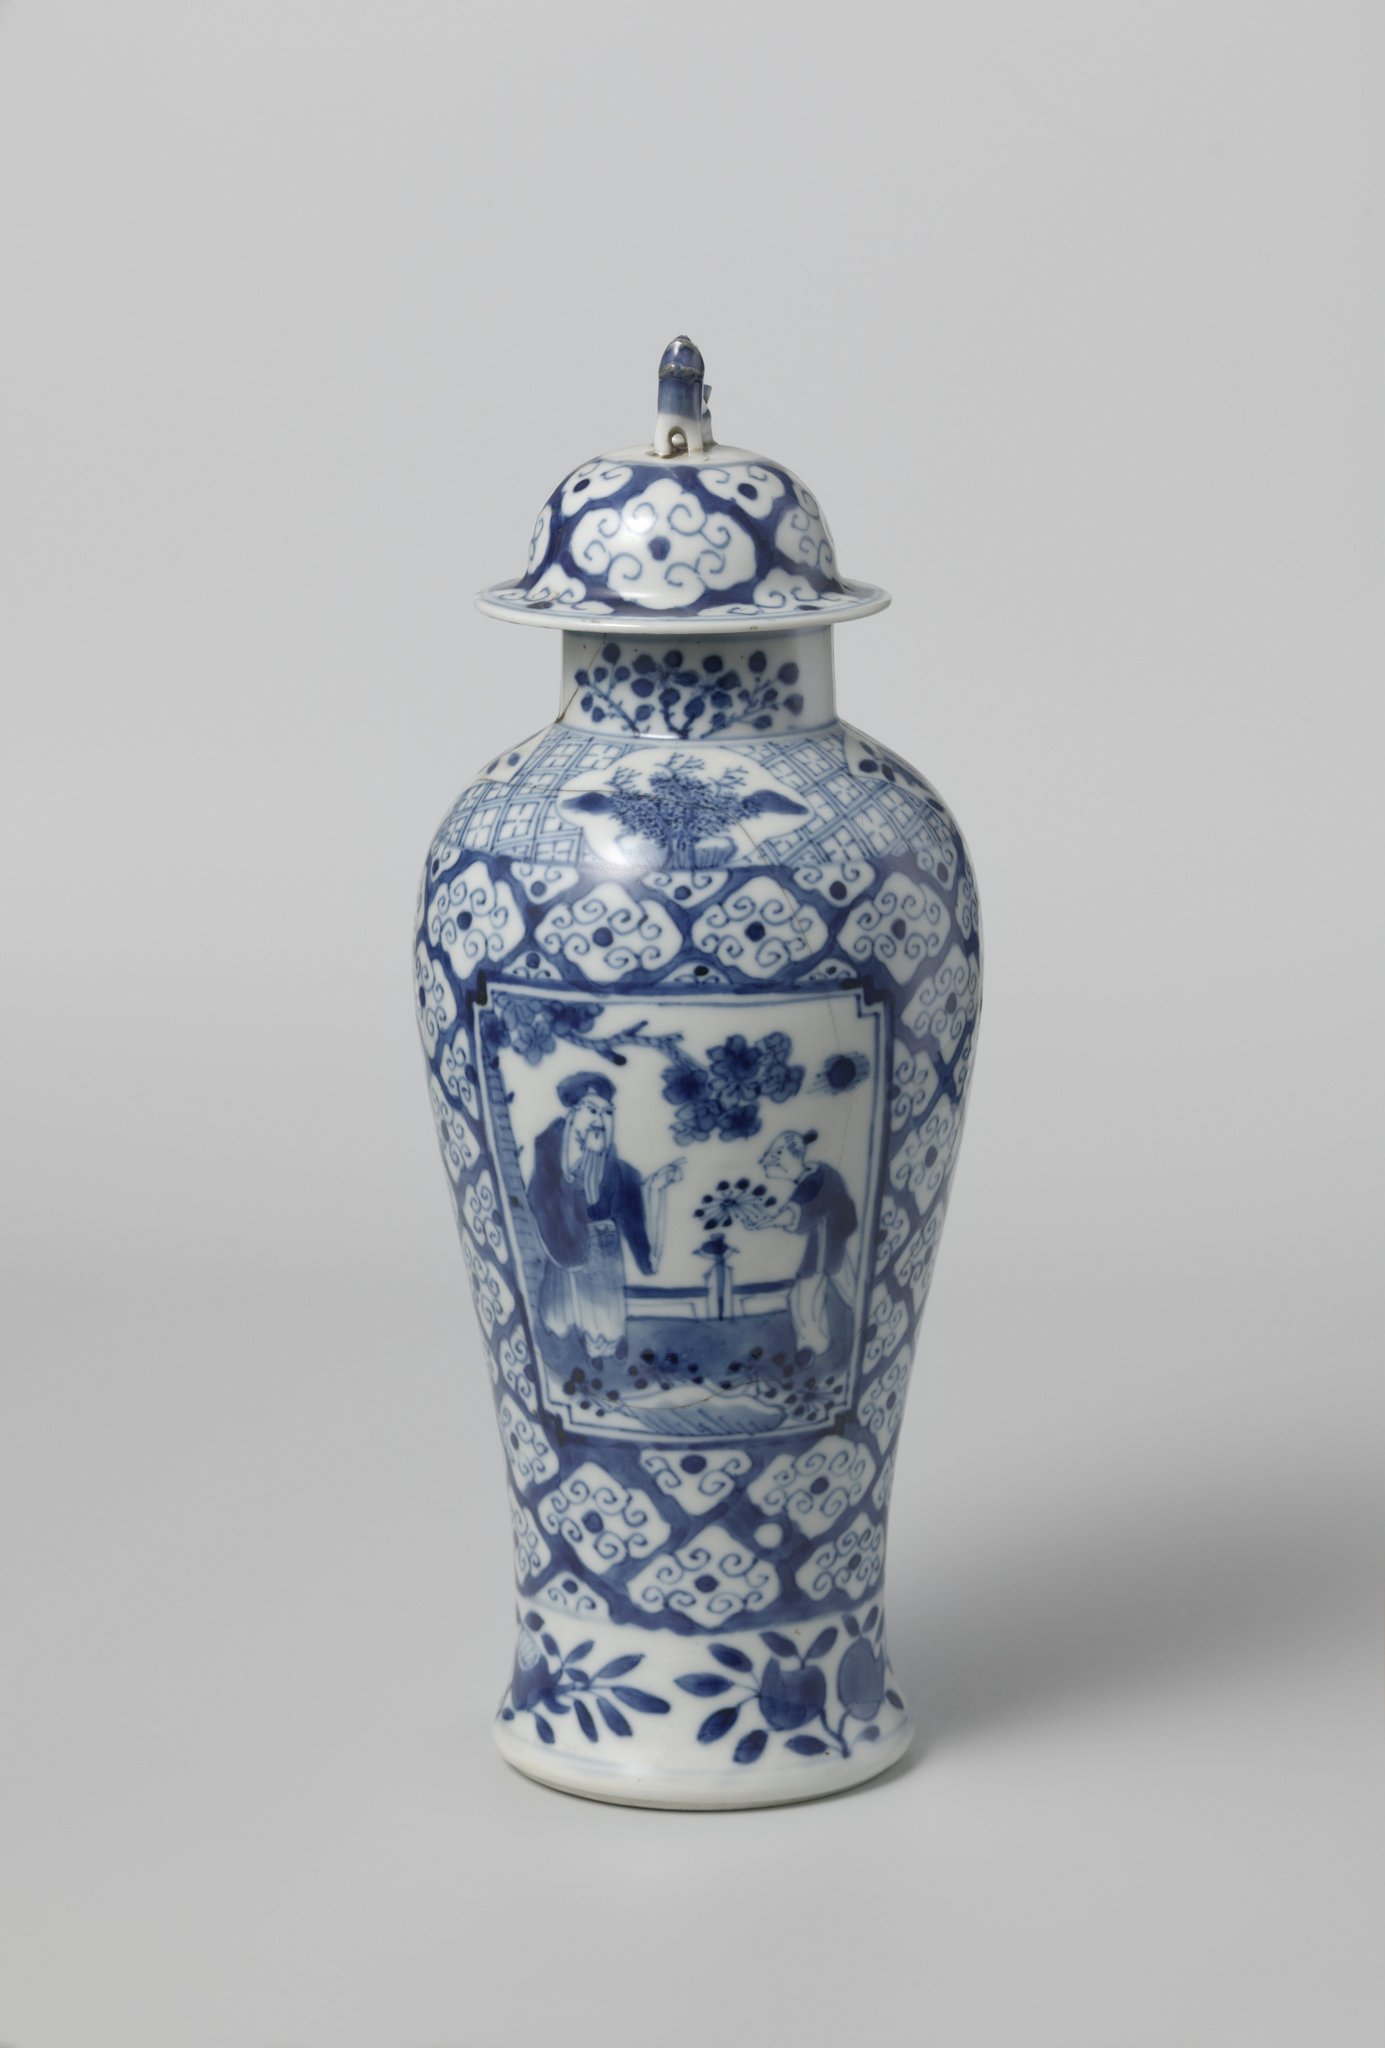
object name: covered jar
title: Baluster covered jar with figures in panels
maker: Anonymous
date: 1875-1899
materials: cobalt, glaze, paint, porcelain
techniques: firing, turning, vitrification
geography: china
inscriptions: mark: ‘康 熙 年 製’